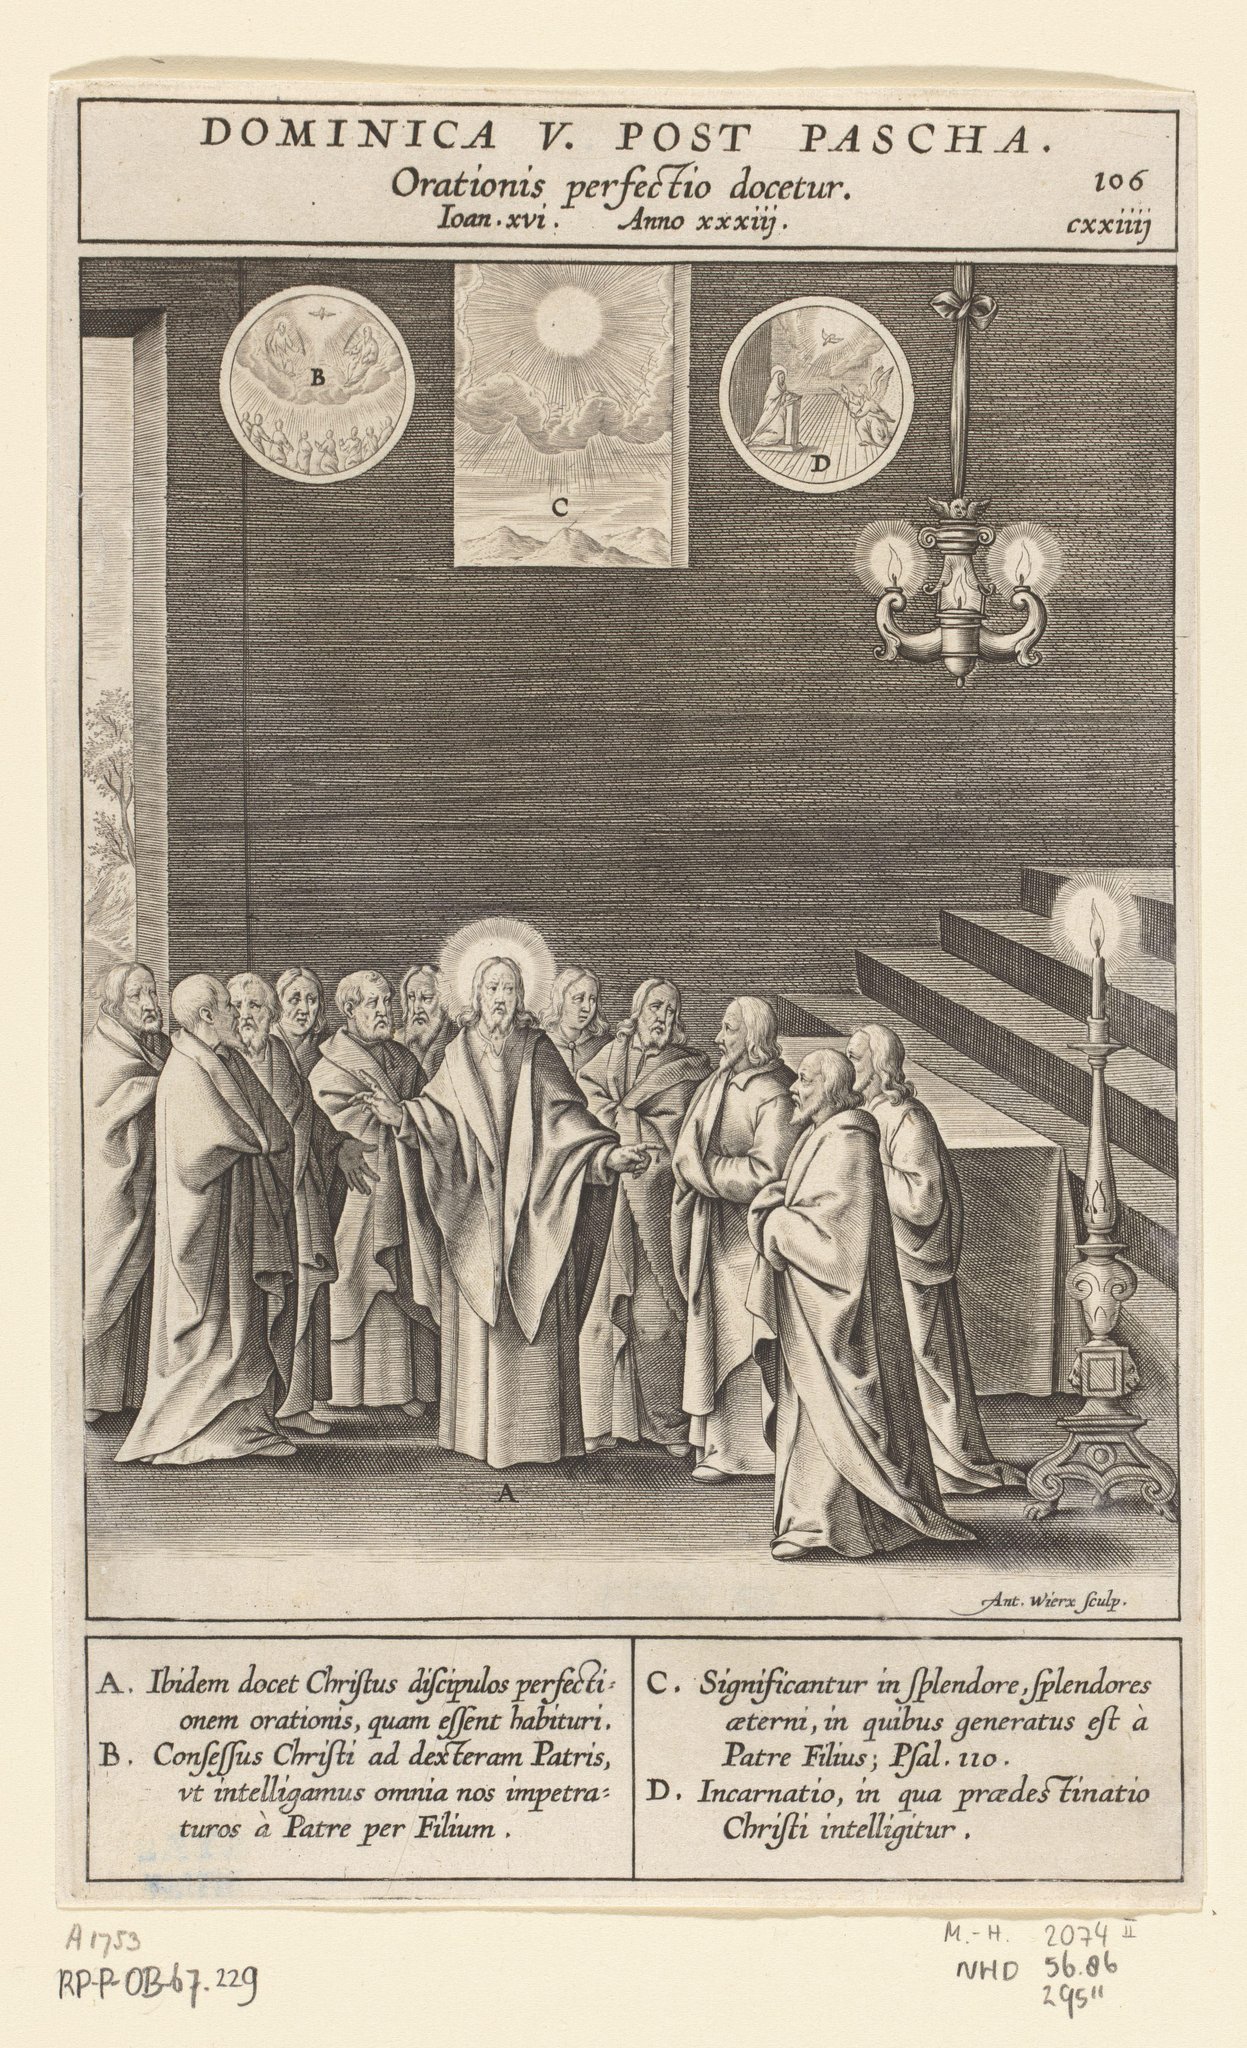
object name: print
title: Dominica V. Post Pascha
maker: antonie wierix (ii)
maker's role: draughtsman, print maker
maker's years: 1555-1604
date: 1593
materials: paper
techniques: engraving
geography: antwerp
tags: christ's conditions for prayer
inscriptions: collector's mark: Lugt 2165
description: Christus predikt tegenover zijn leerlingen. Hij vertelt hen: "Als je dan iets vraagt in mijn naam, hoef ik het niet meer namens jullie aan de Vader te vragen, want de Vader zelf heeft jullie lief, omdat jullie mij liefhebben en geloven dat ik van God ben gekomen." Bij verschillende elementen uit de voorstelling staan letters die corresponderen met de legenda in de marge.